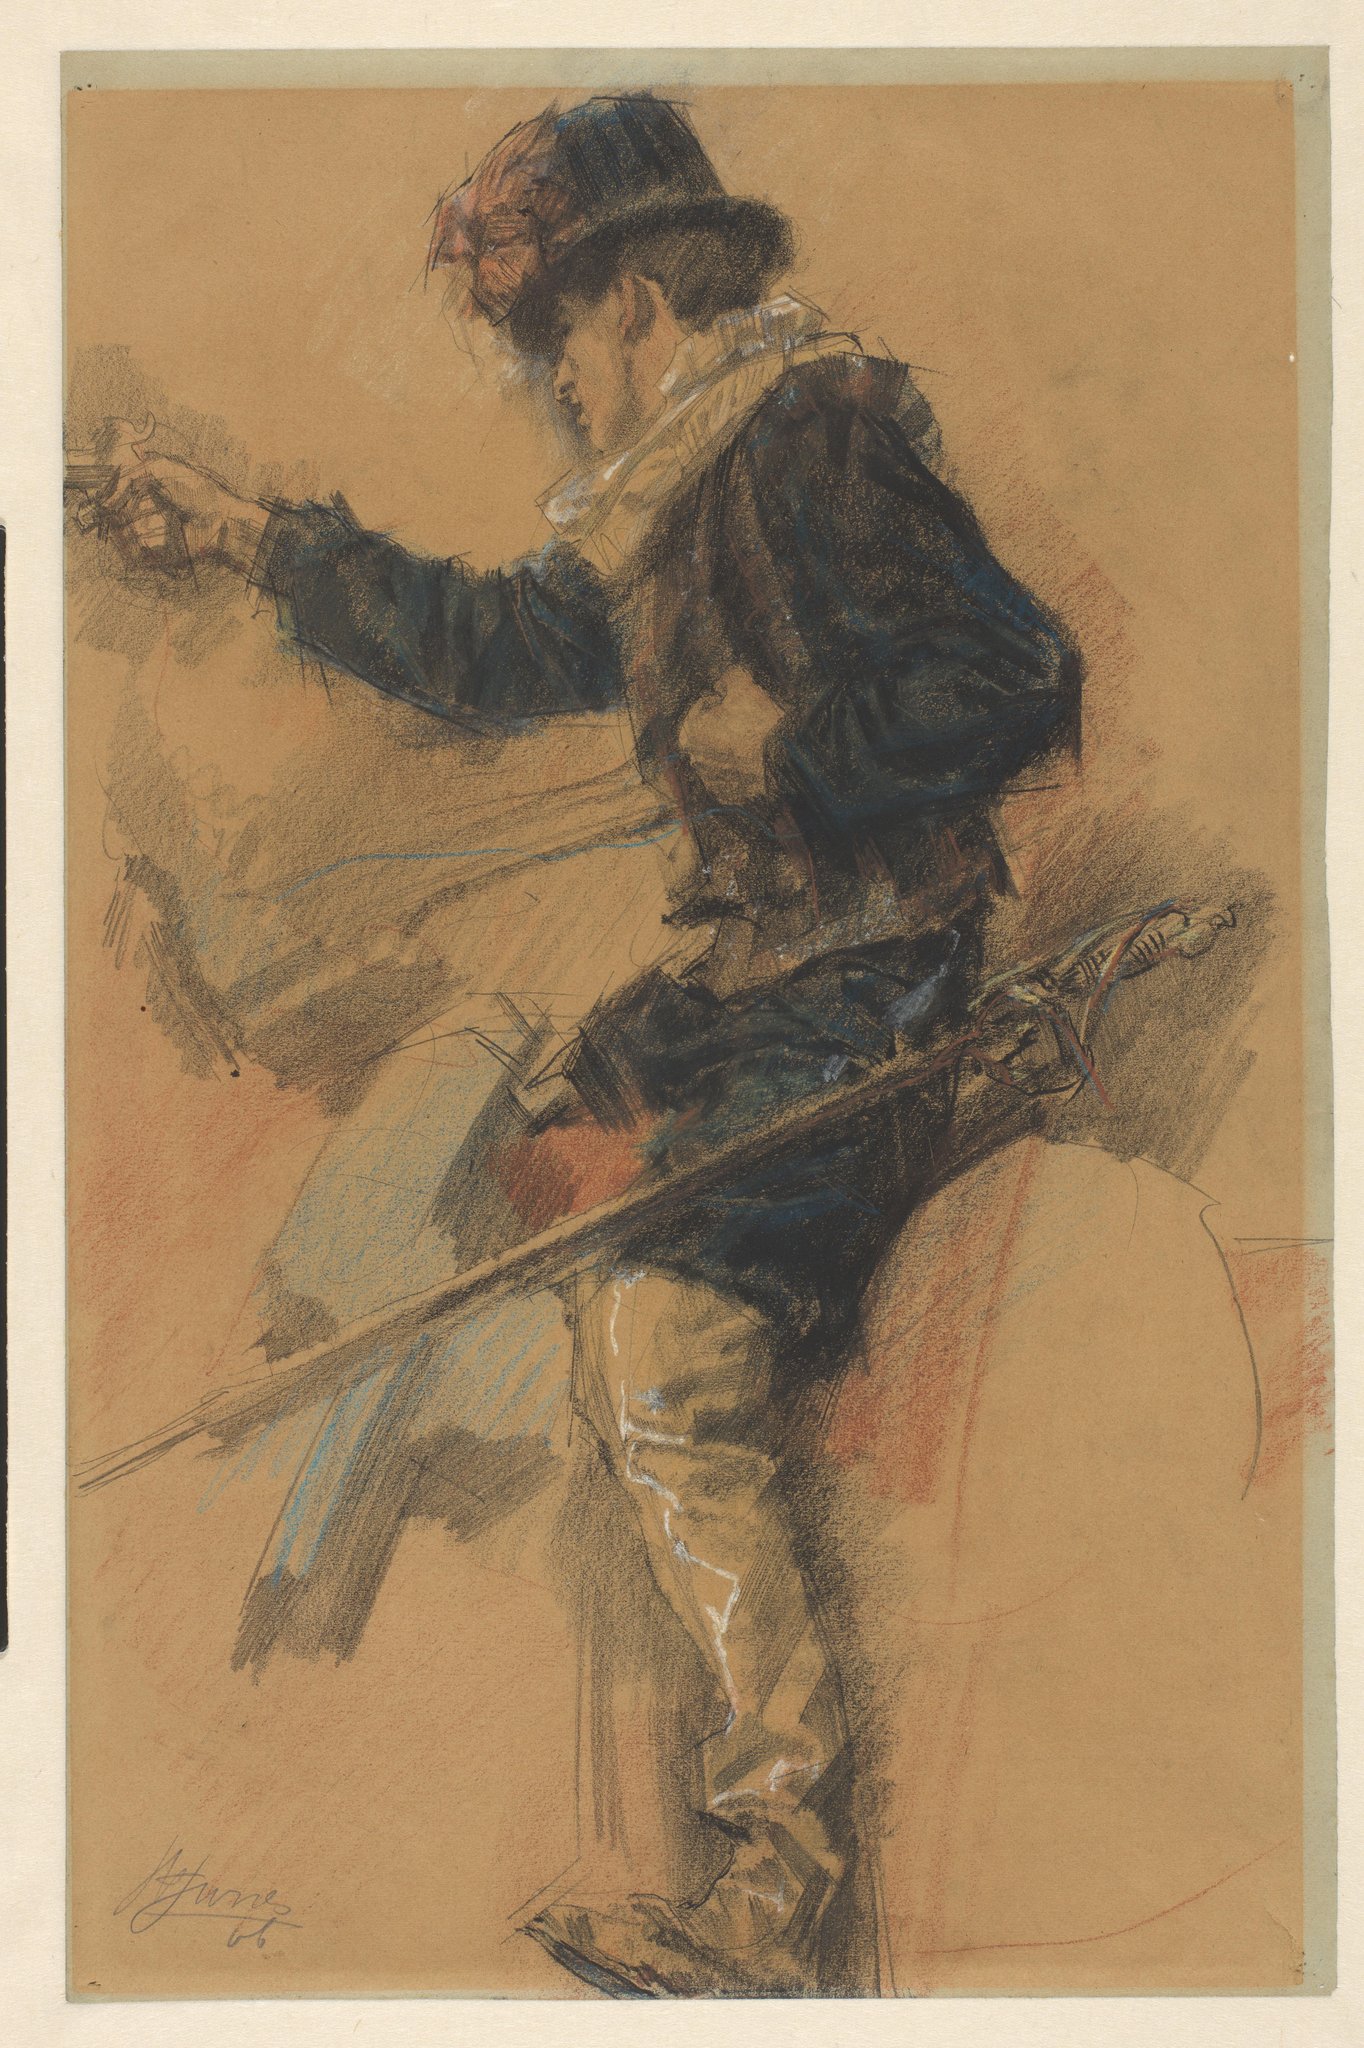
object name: drawing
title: Soldaat te paard, in Spaanse dracht met getrokken pistool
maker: johannes hendricus jurres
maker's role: draughtsman, print maker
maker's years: 1875-1946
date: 1885-1946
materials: chalk, paper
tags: land forces (+ cavalry, horsemen)